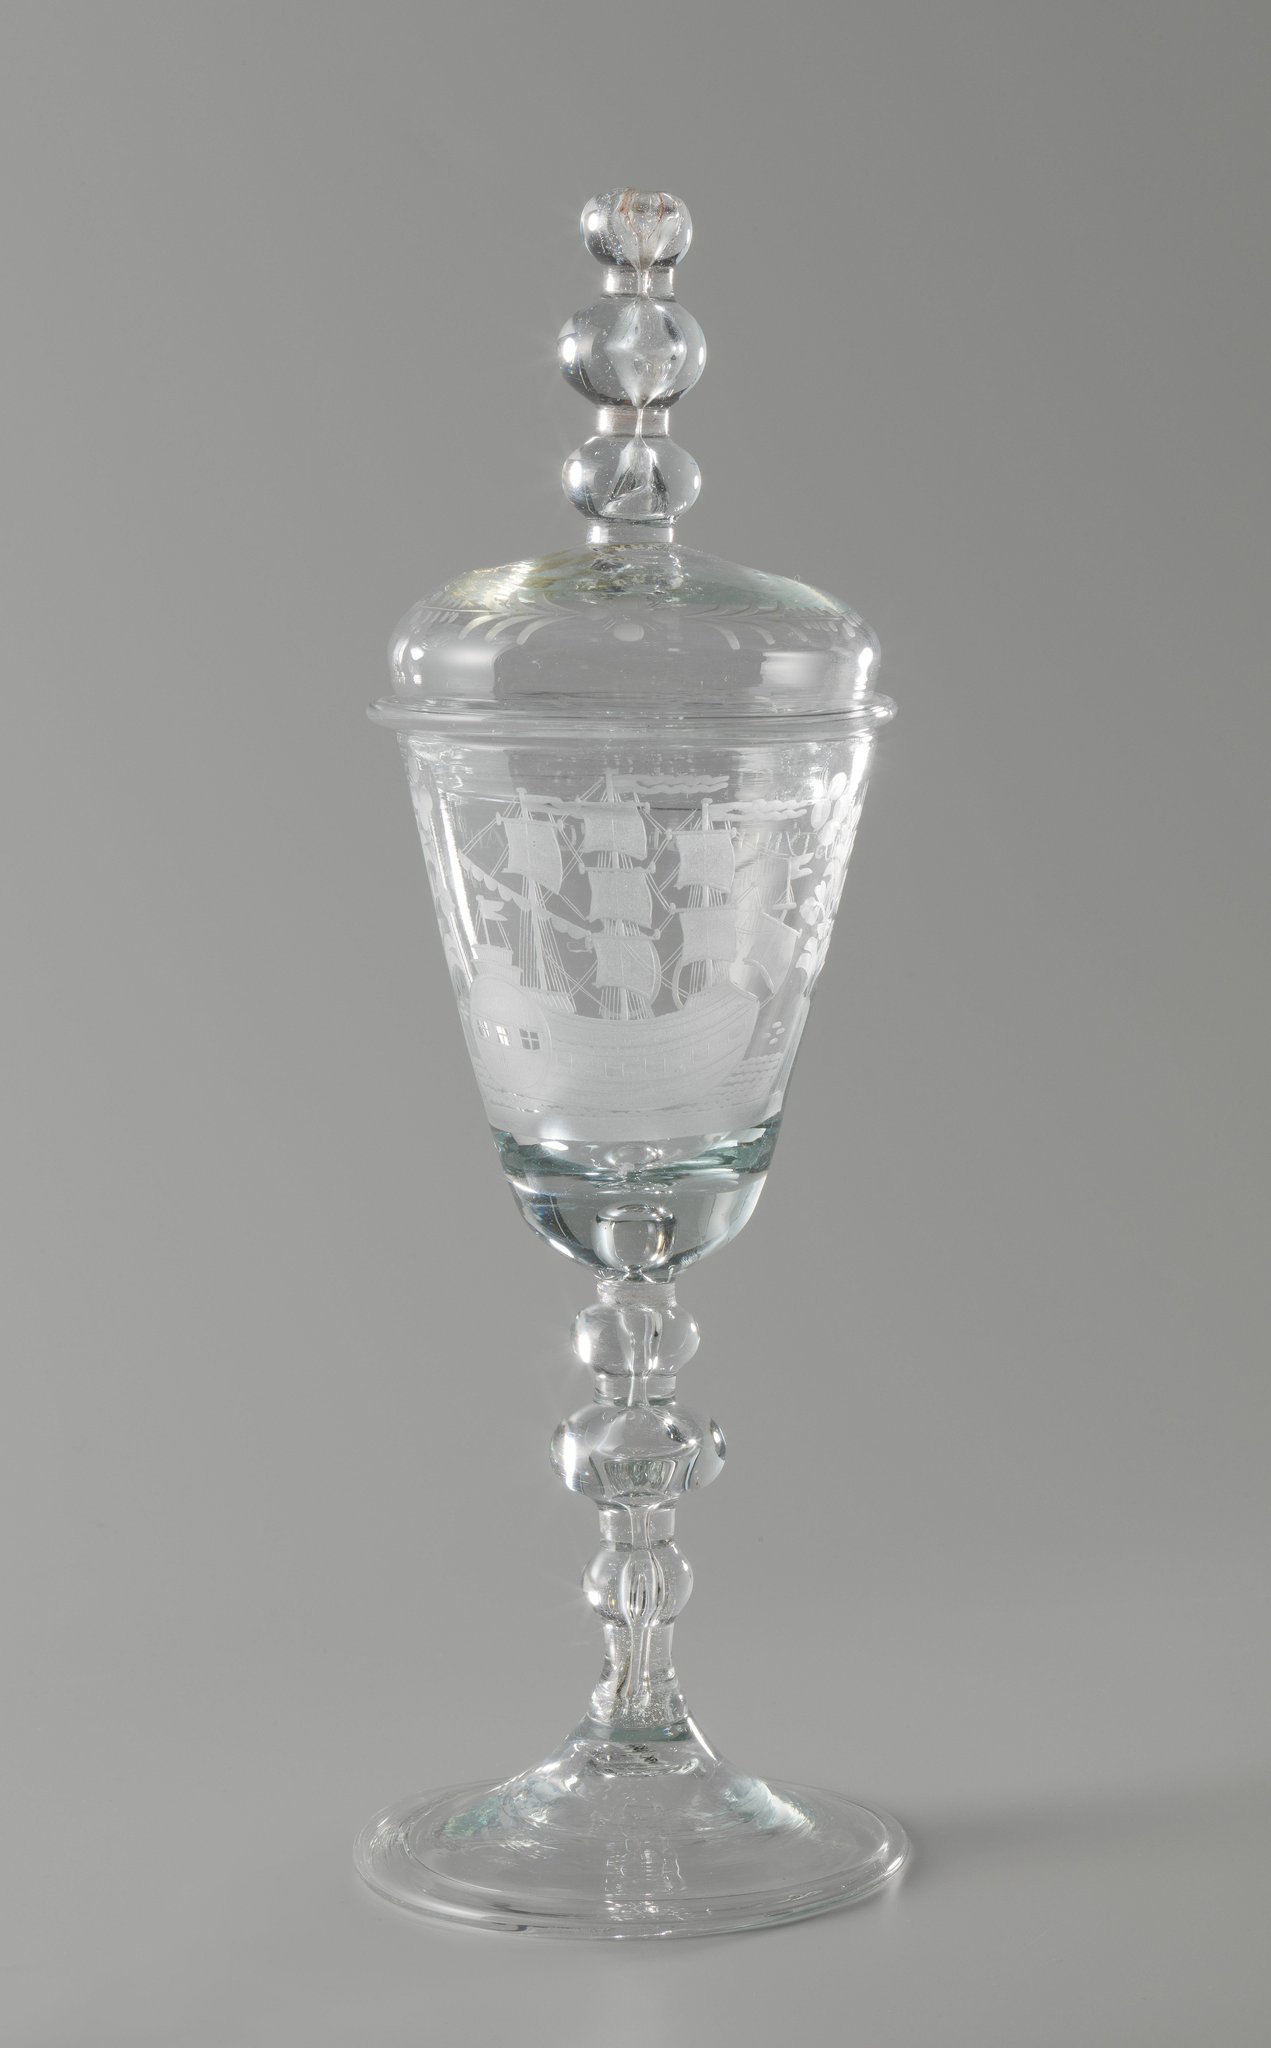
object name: lid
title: Deksel van bokaal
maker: Anonymous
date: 1725-1750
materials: glass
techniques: glassblowing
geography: germany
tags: verenigde oostindische compagnie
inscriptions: inscription: ‘HET WEL VAREN VAN DE OOSTYNDYESE KOMPANIE’, inscription: ‘VOC’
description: Het glas in gelegateerd met deksel. Het deksel is echter niet oorspronkelijk.